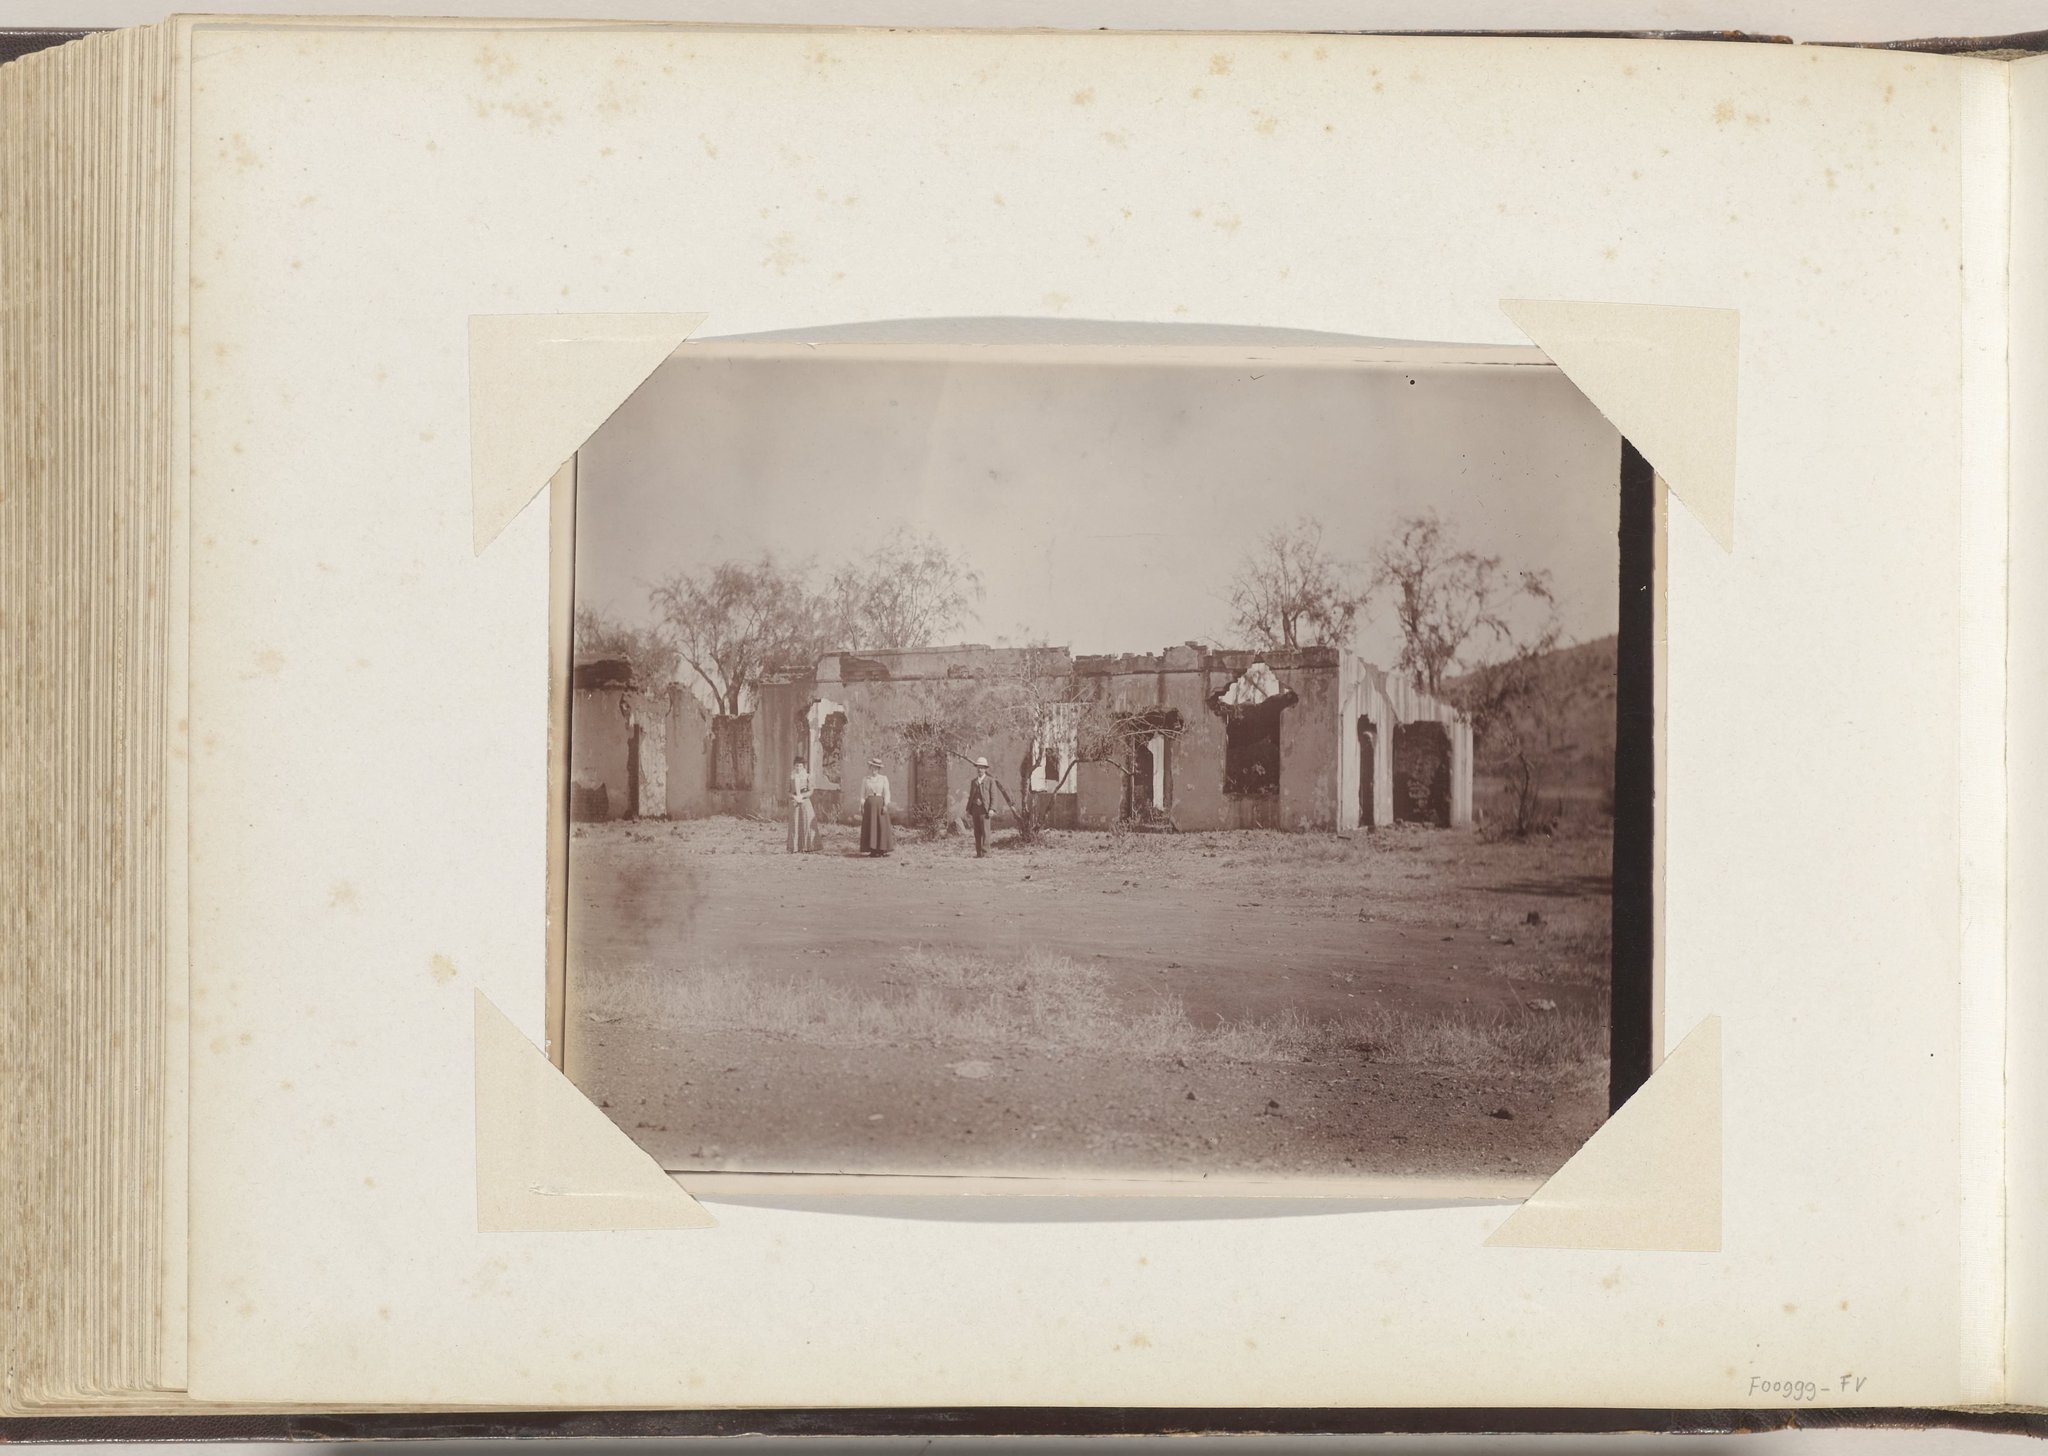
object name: photograph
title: Vrouwen en man poserend voor verwoest huis in Zuid-Afrika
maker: Anonymous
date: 1899-1902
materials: paper, photographic support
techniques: gelatin silver print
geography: south africa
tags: ruin of a dwelling, house, castle, etc.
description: Onderdeel van Album met 191 foto's van een reis naar en door Zuid-Afrika.